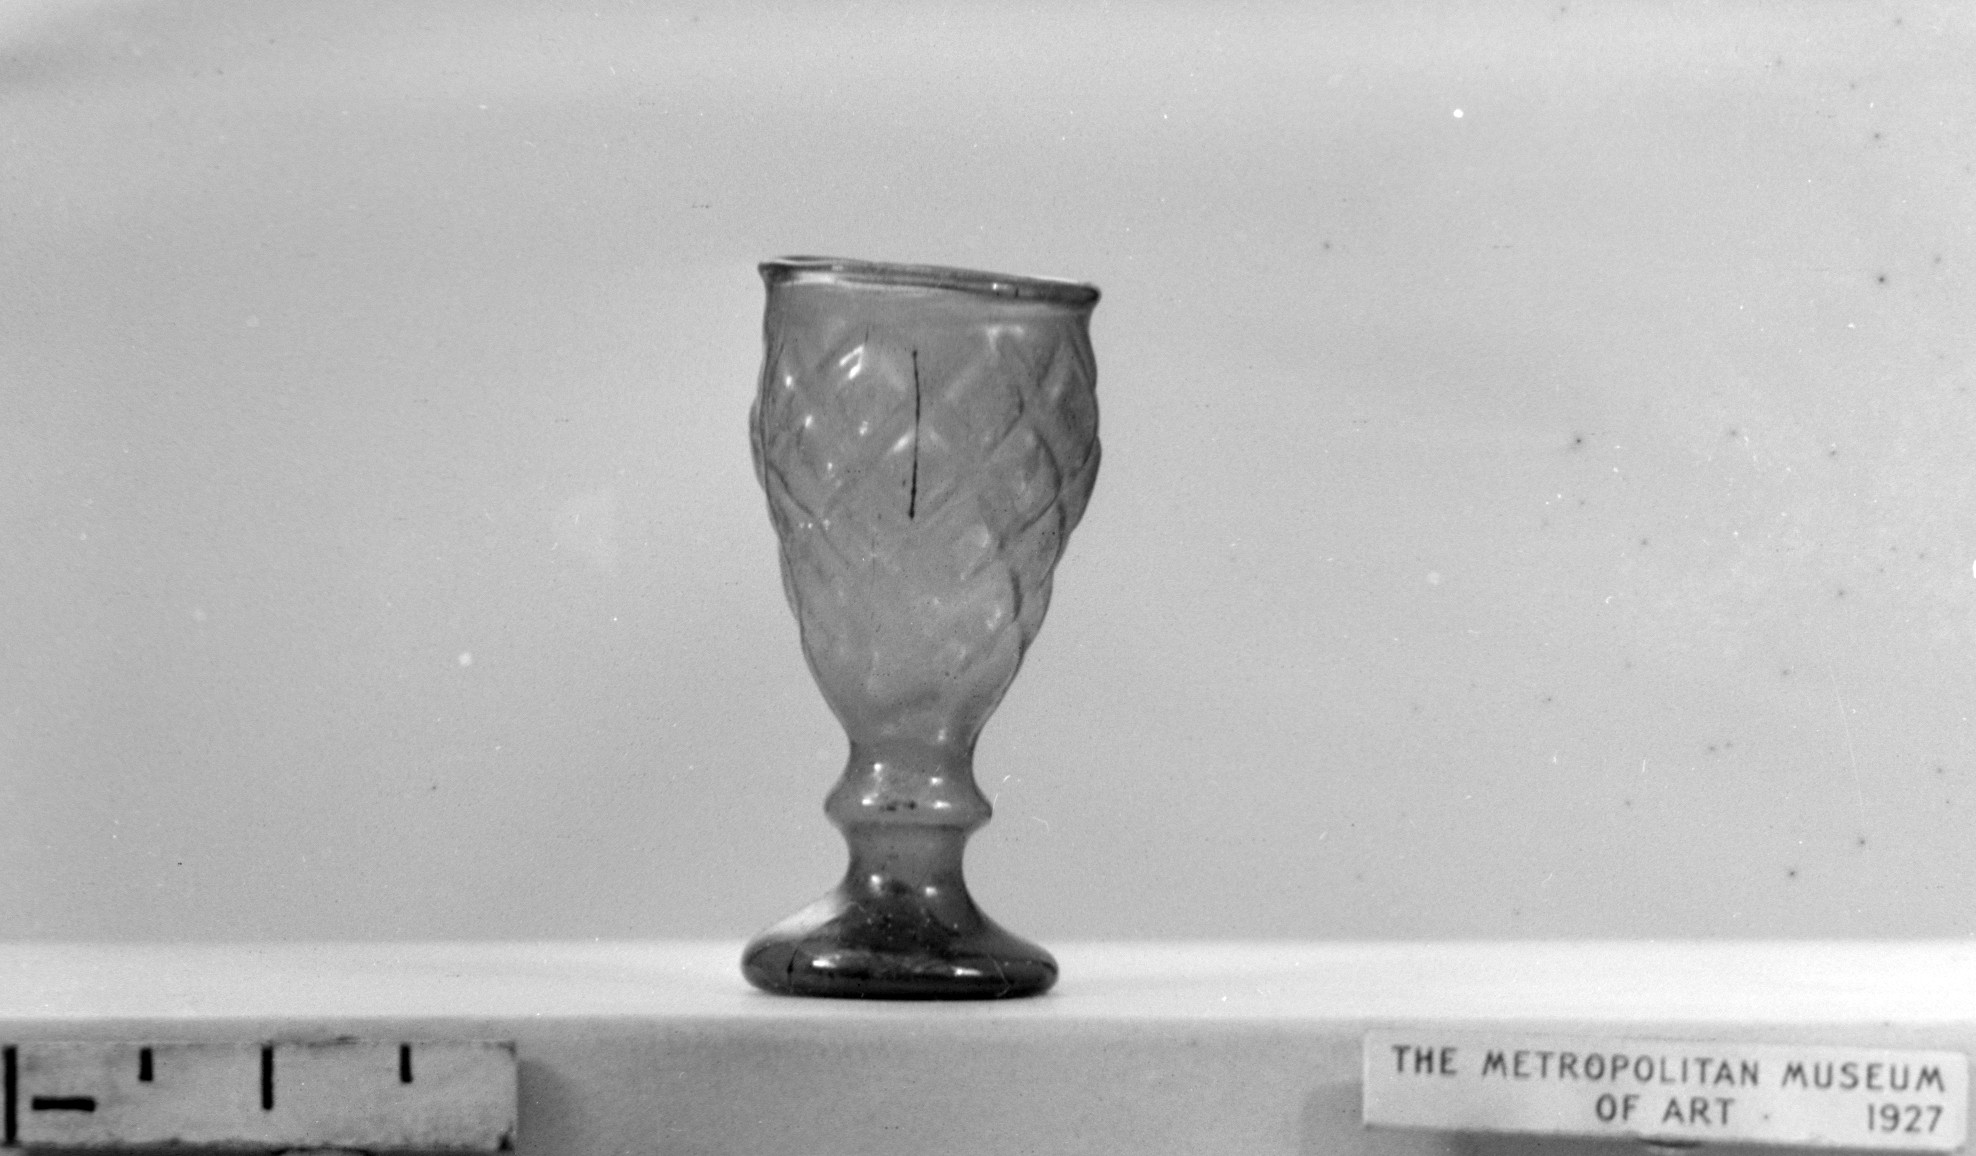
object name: goblet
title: Miniature goblet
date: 1801-1833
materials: glass